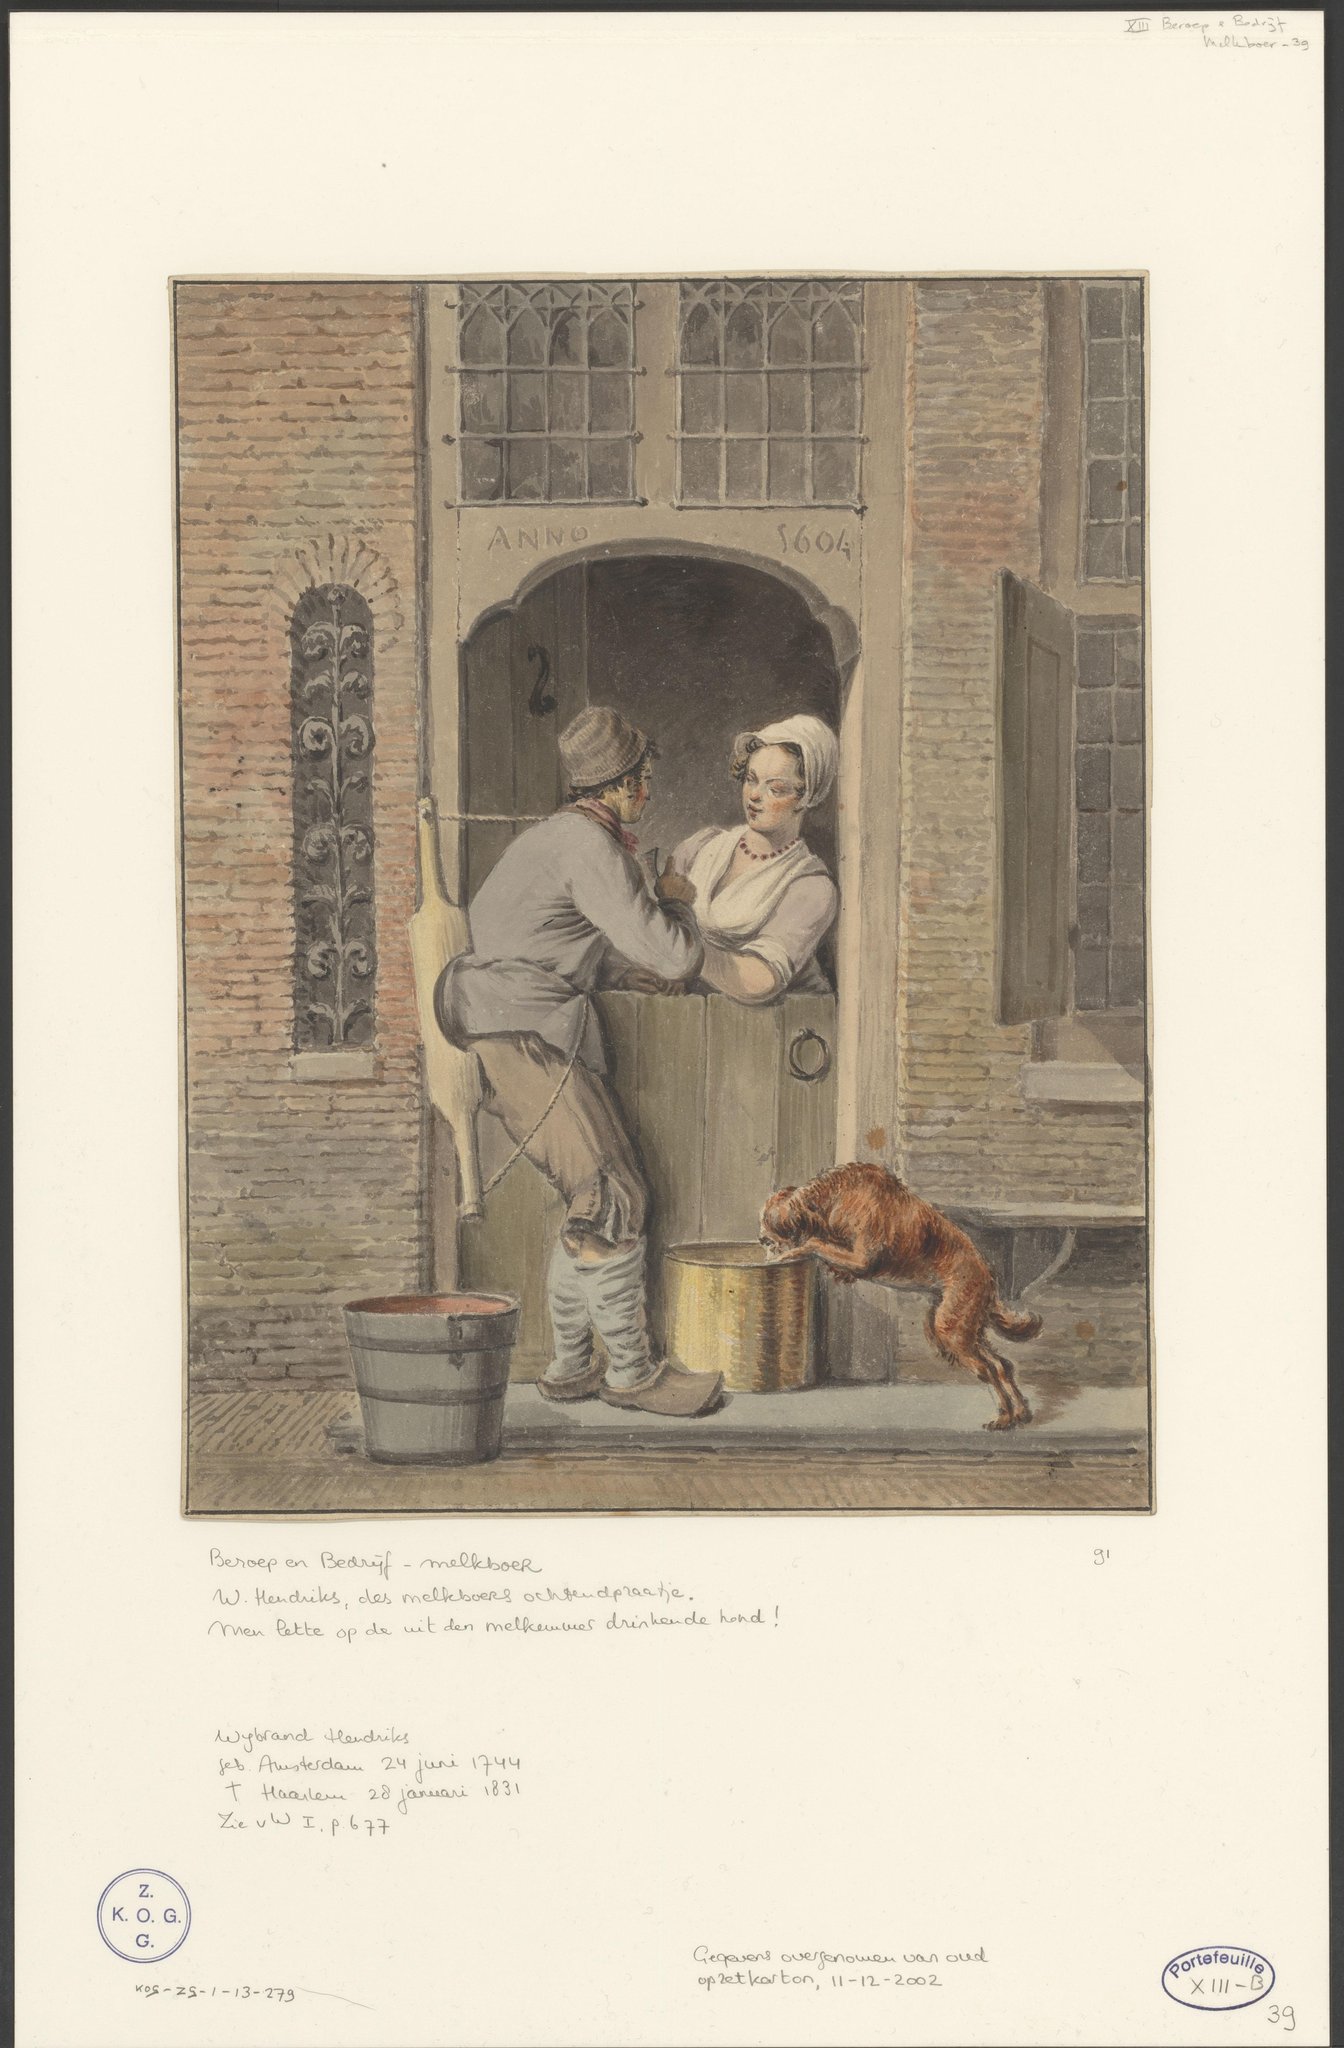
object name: drawing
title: Melkboer praat met een keukenmeid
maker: wybrand hendriks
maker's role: draughtsman, painter, print maker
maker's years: 1744-1831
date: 1754-1831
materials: chalk, paper, watercolor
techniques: brush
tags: carrying something with yoke, transportation of milk, dog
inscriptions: stamp, collector's mark: Lugt 1641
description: Onderwerpsrubrieken binnen de Atlas Zeden en Gewoonten: Handel, Nijverheid en Verkeer, Beroep en bedrijf, Mannelijk, Eet- en drinkwaren.